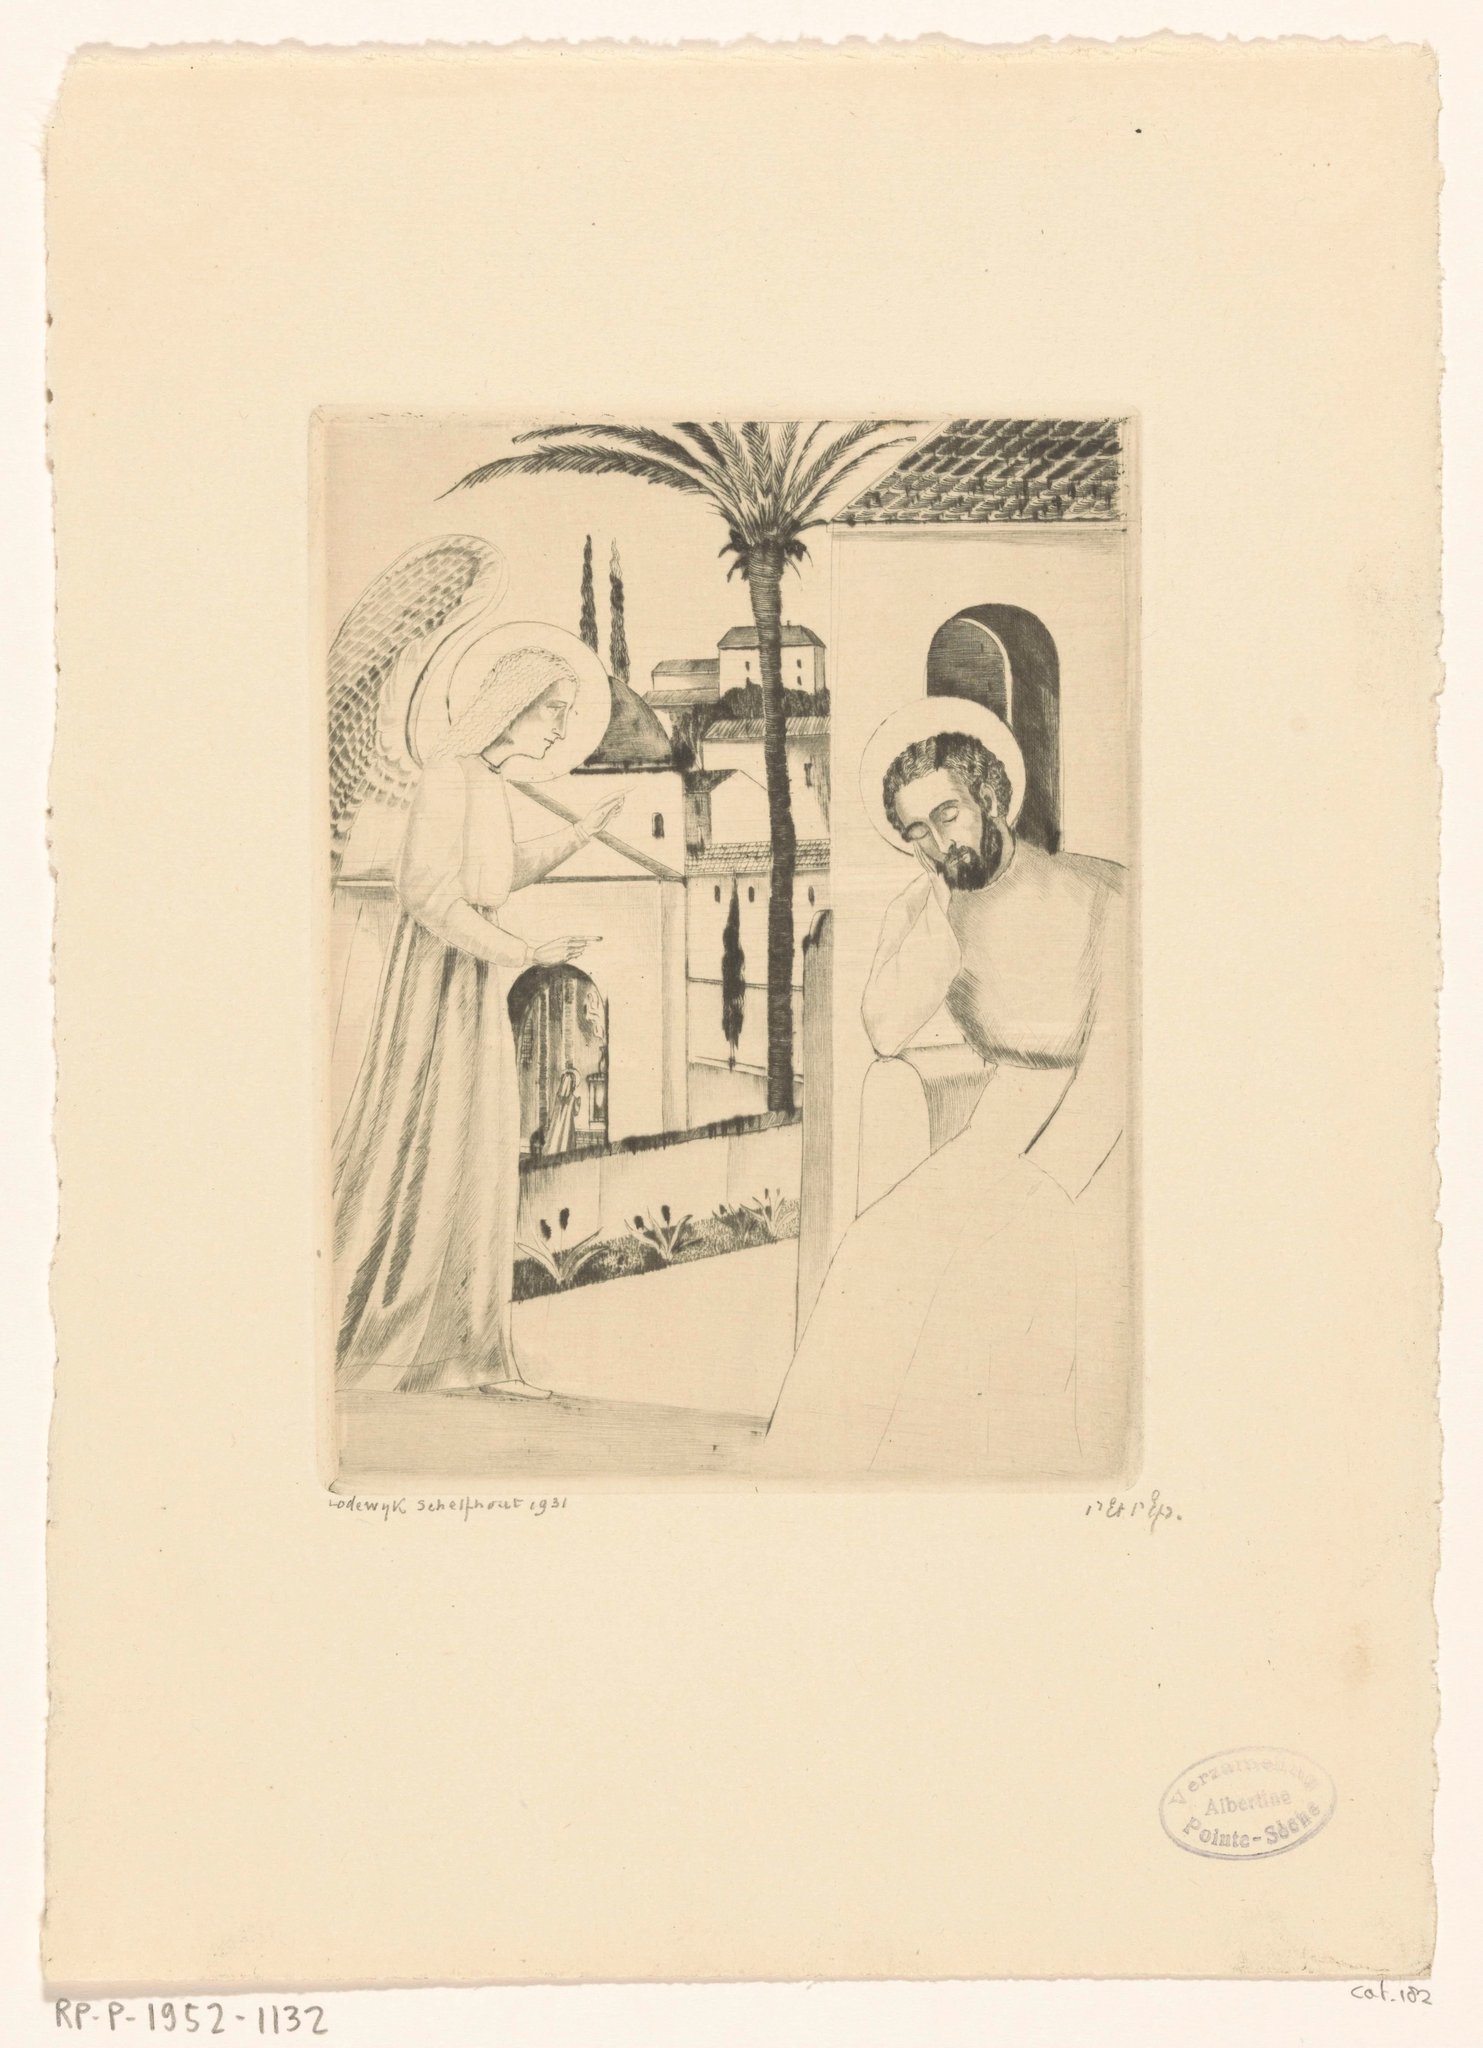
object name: print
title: Jozefs droom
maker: lodewijk schelfhout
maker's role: draughtsman, print maker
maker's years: 1881-1943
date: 1931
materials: paper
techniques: drypoint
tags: the foster-father of christ, joseph of nazareth, husband of mary; possible attributes: flowering rod or wand, lily, carpenter's tools, dream, angels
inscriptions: collector's mark: Lugt 5i, collector's mark: Lugt 2228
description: Rechts op de voorgrond Jozef, slapend op een bank in een tuin. Links de aartsengel Gabriël, die aan Jozef verschijnt in een droom. Op de achtergrond gebouwen.